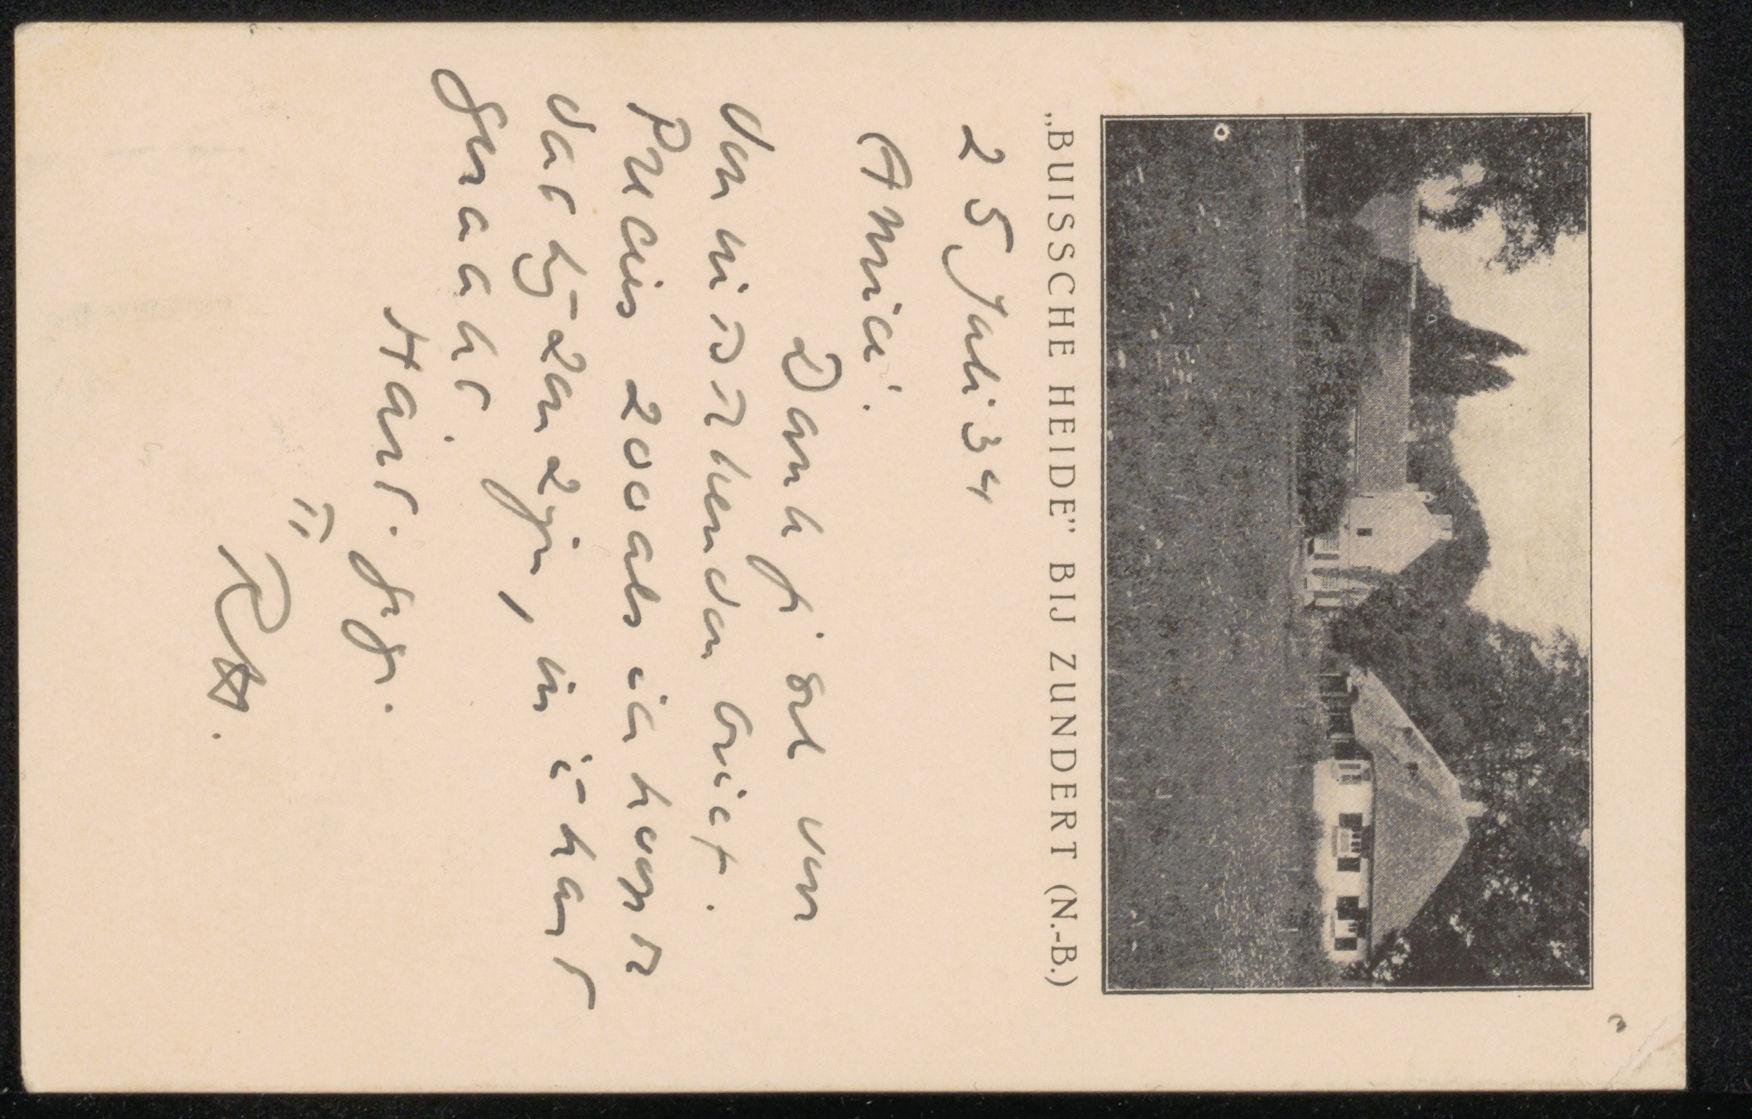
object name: ansichtkaart, prentbriefkaart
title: Prentbriefkaart aan Willem Bogtman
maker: richard nicolaüs roland holst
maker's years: 1868-1938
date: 1934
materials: cardboard, ink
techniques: pen, writing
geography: zundert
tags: amsterdam, draughtsman, louis boermeester, haarlem, willem bogtman